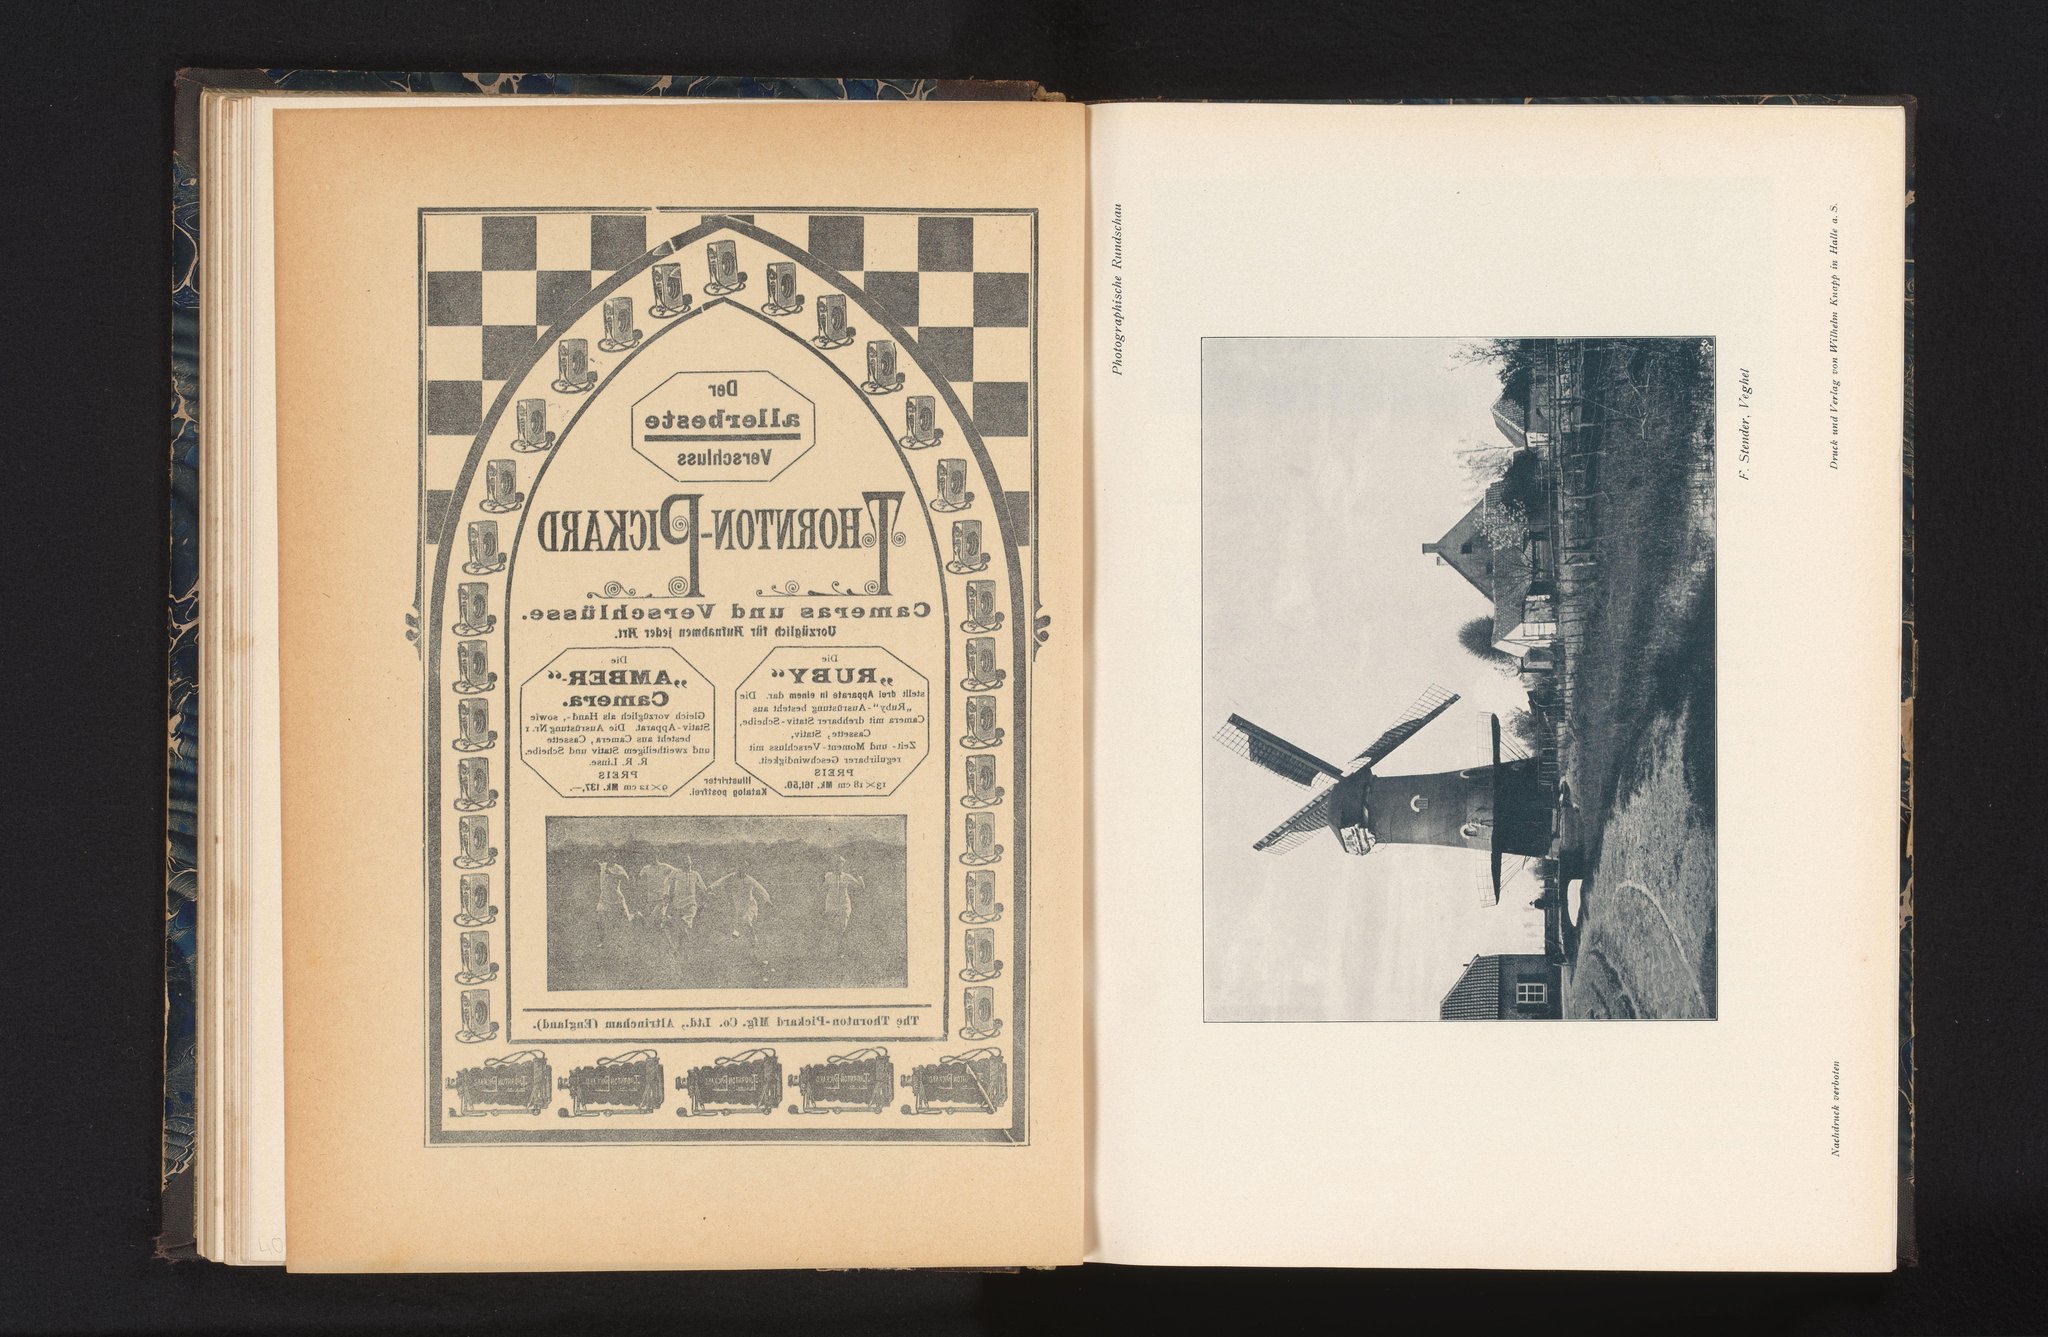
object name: photomechanical print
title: Gezicht op een molen en een aantal huizen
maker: f. stender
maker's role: fotograaf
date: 1897-1902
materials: paper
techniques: autotype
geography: berlin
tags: housing, windmill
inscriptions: monogram: ‘MR&C’